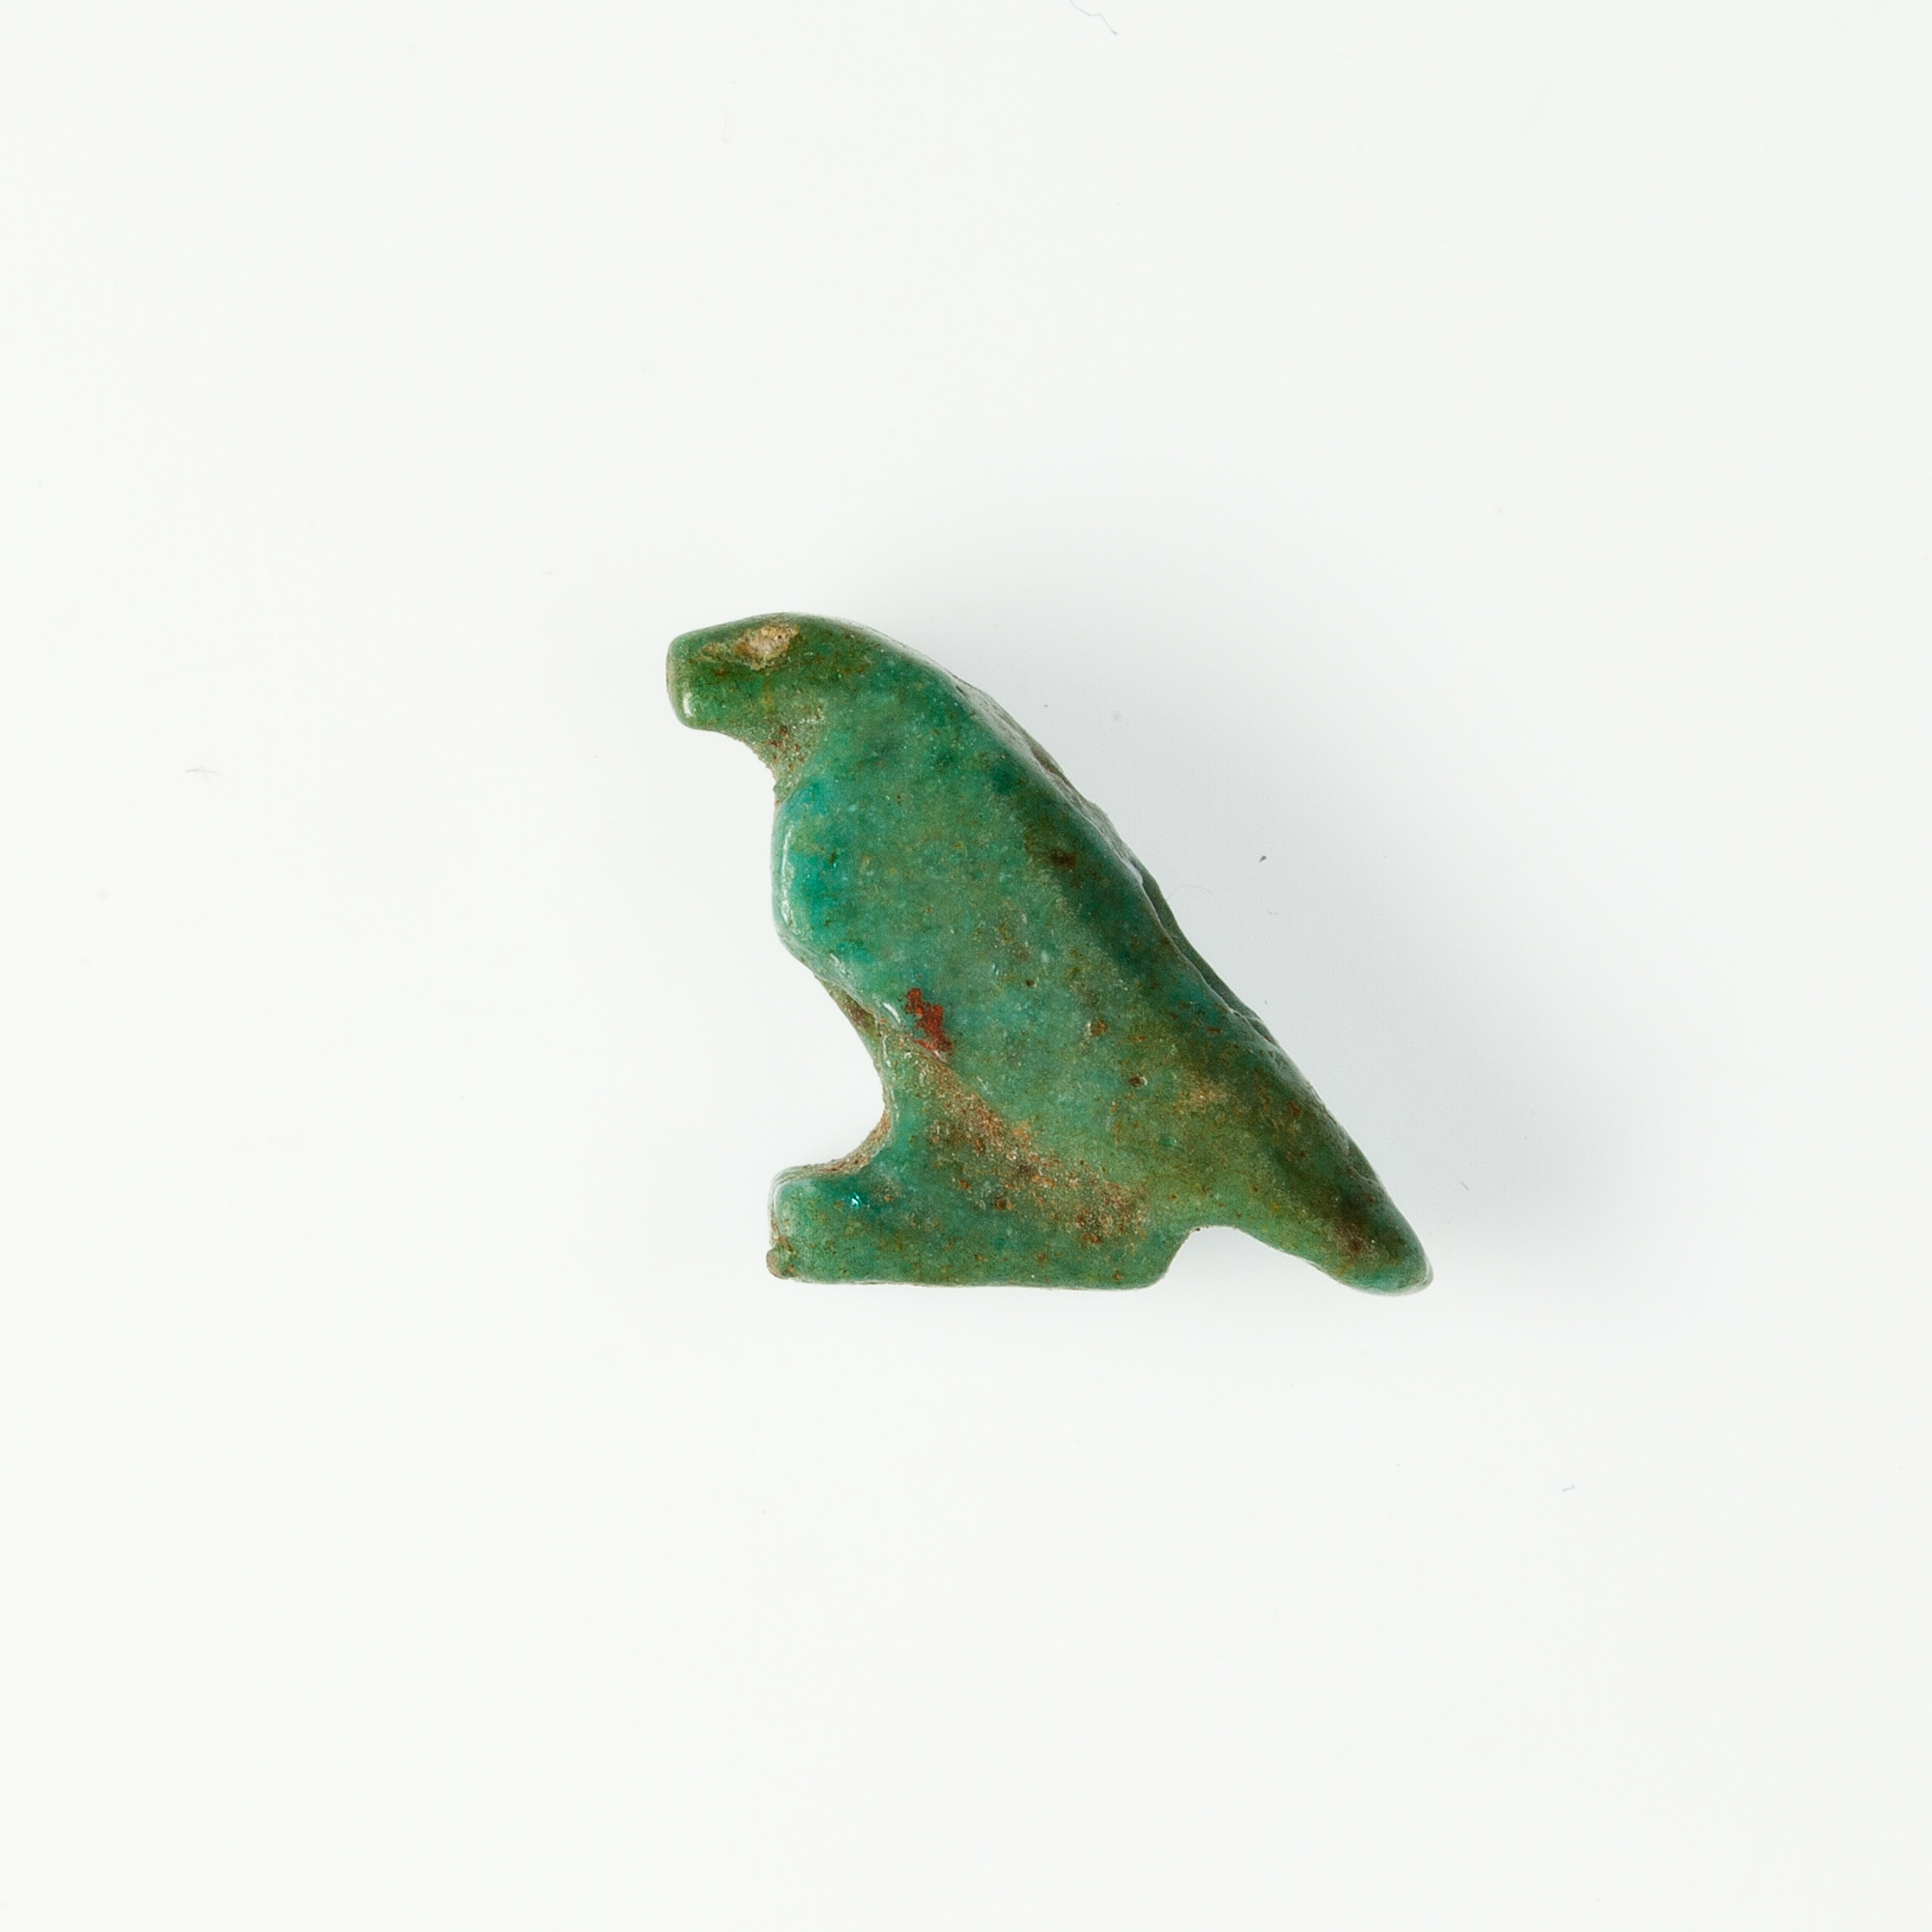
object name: amulet, falcon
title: Falcon amulet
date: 2040-1640 BCE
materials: faience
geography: egypt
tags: falcons